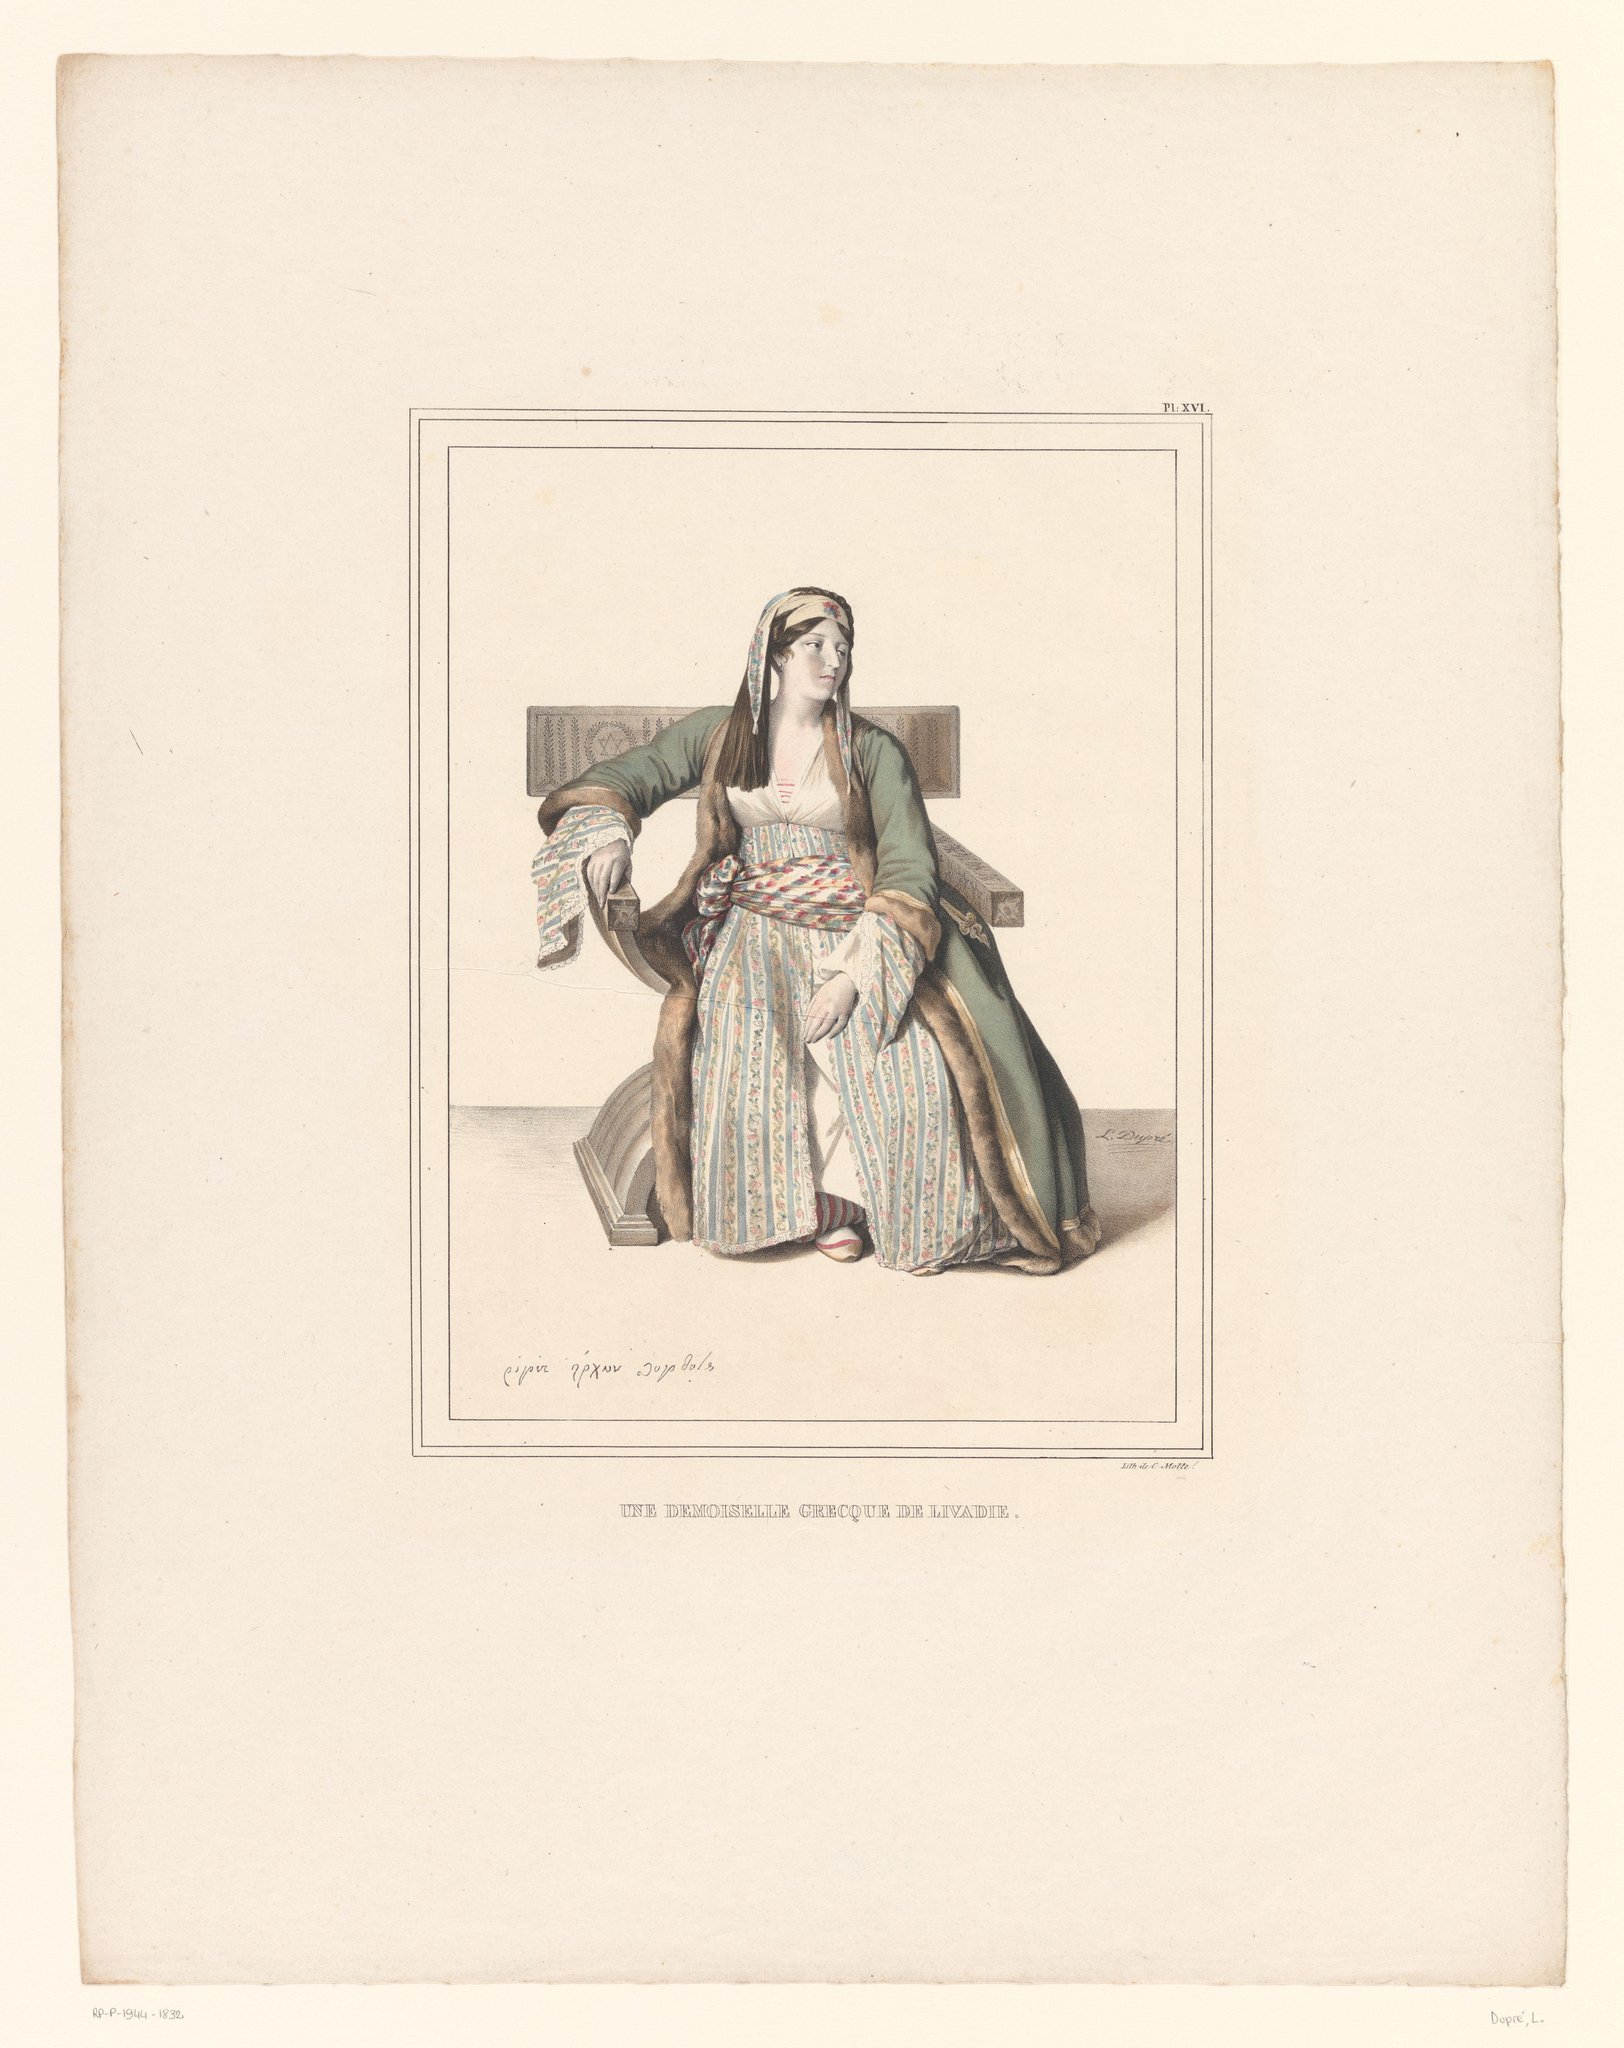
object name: print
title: Portret van een onbekende jonge Griekse vrouw uit Livádi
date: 1825-1837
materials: paper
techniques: hand coloring, lithograph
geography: paris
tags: sitting figure - aa - female human figure, chair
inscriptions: check stamp: ‘LD’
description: De prent maakt deel uit van de serie 'Voyage à Athènes et à Constantinople ou collection de portraits, de vues et de costumes Grecs et Ottomans' die tussen 1825 en 1839 in tien delen van vier prenten werd uitgebracht. De in totaal veertig prenten dienden samen met een tekst van 52 pagina's voorzien van vignettes als een verslag van de reis die Louis Dupré in 1819 naar Athene en het huidige Istanboel maakte (zie documentatie).